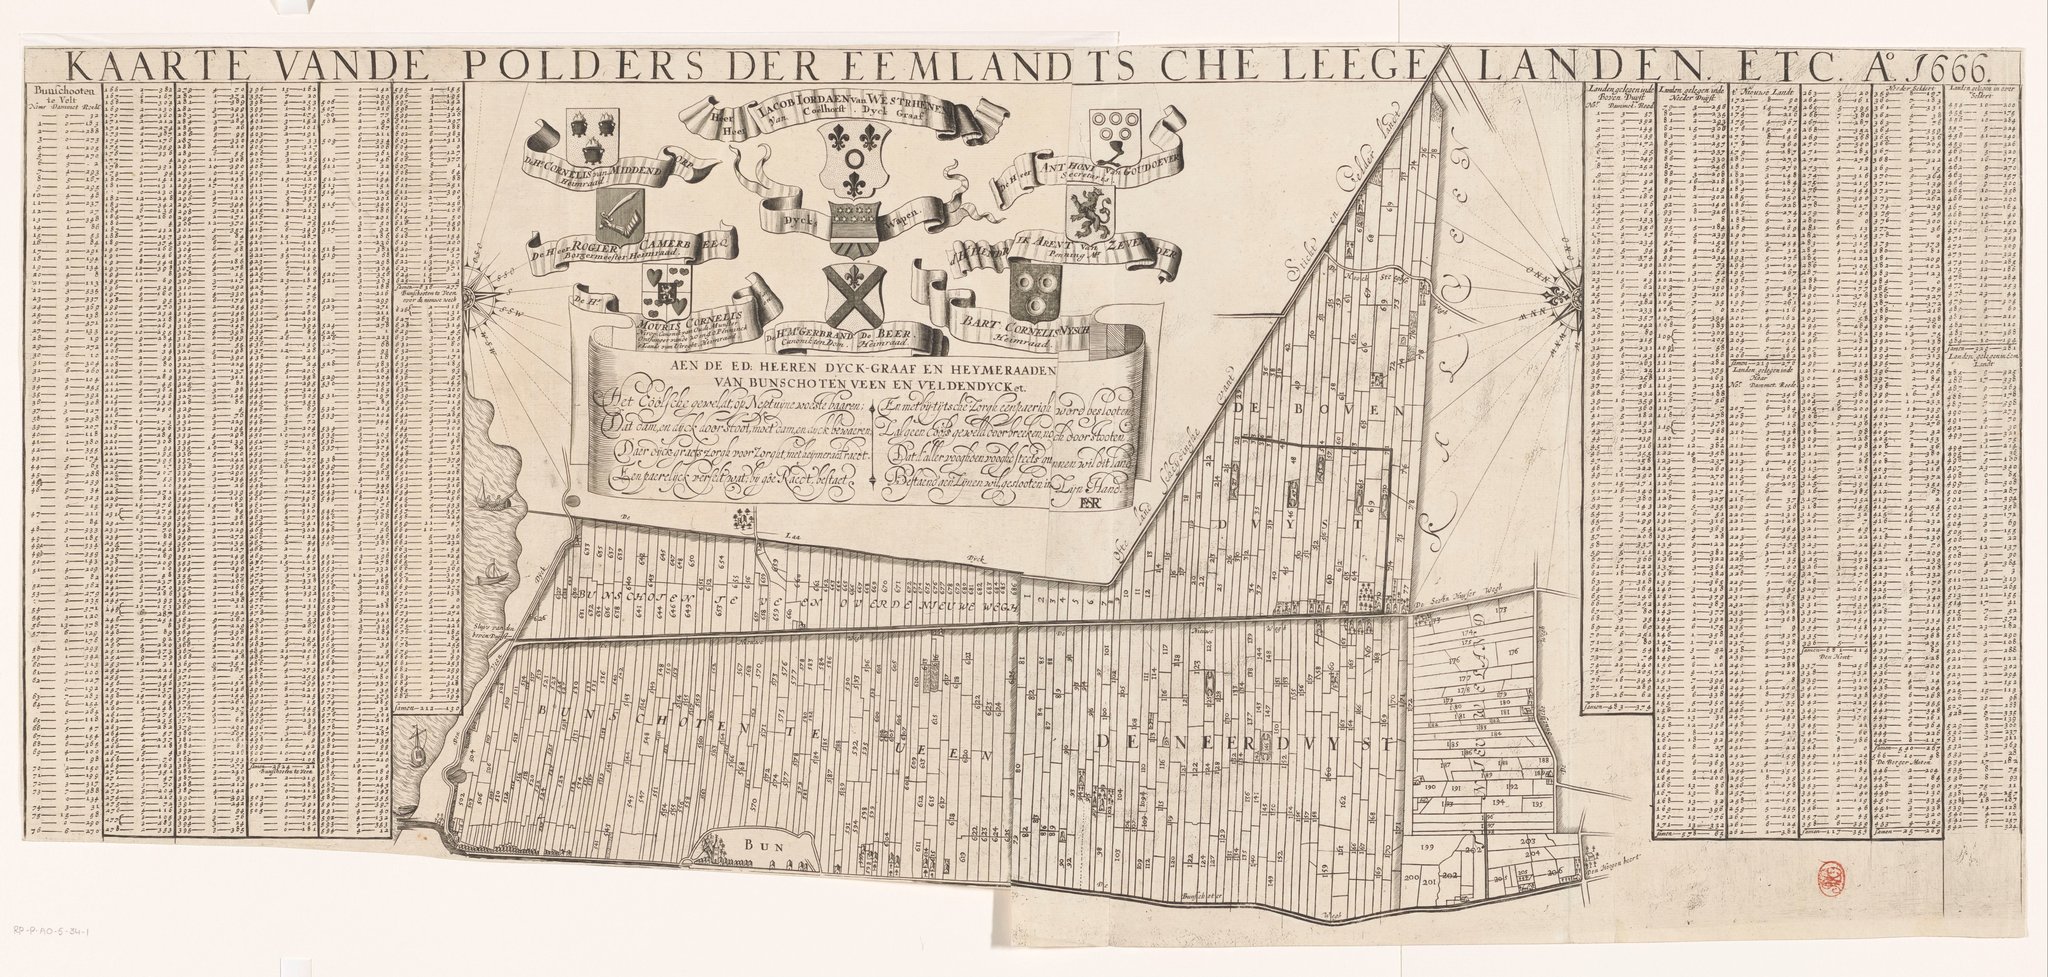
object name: print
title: Kaarte vande polders der Eemlandtsche leege landen etc. Ao. 1666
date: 1666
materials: paper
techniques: engraving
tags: coat of arms (as symbol of the state, etc.), maps of separate countries or regions, polder, reclaimed land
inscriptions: collector's mark: Lugt 195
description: Bovenste deel van een polderkaart van Eemland.